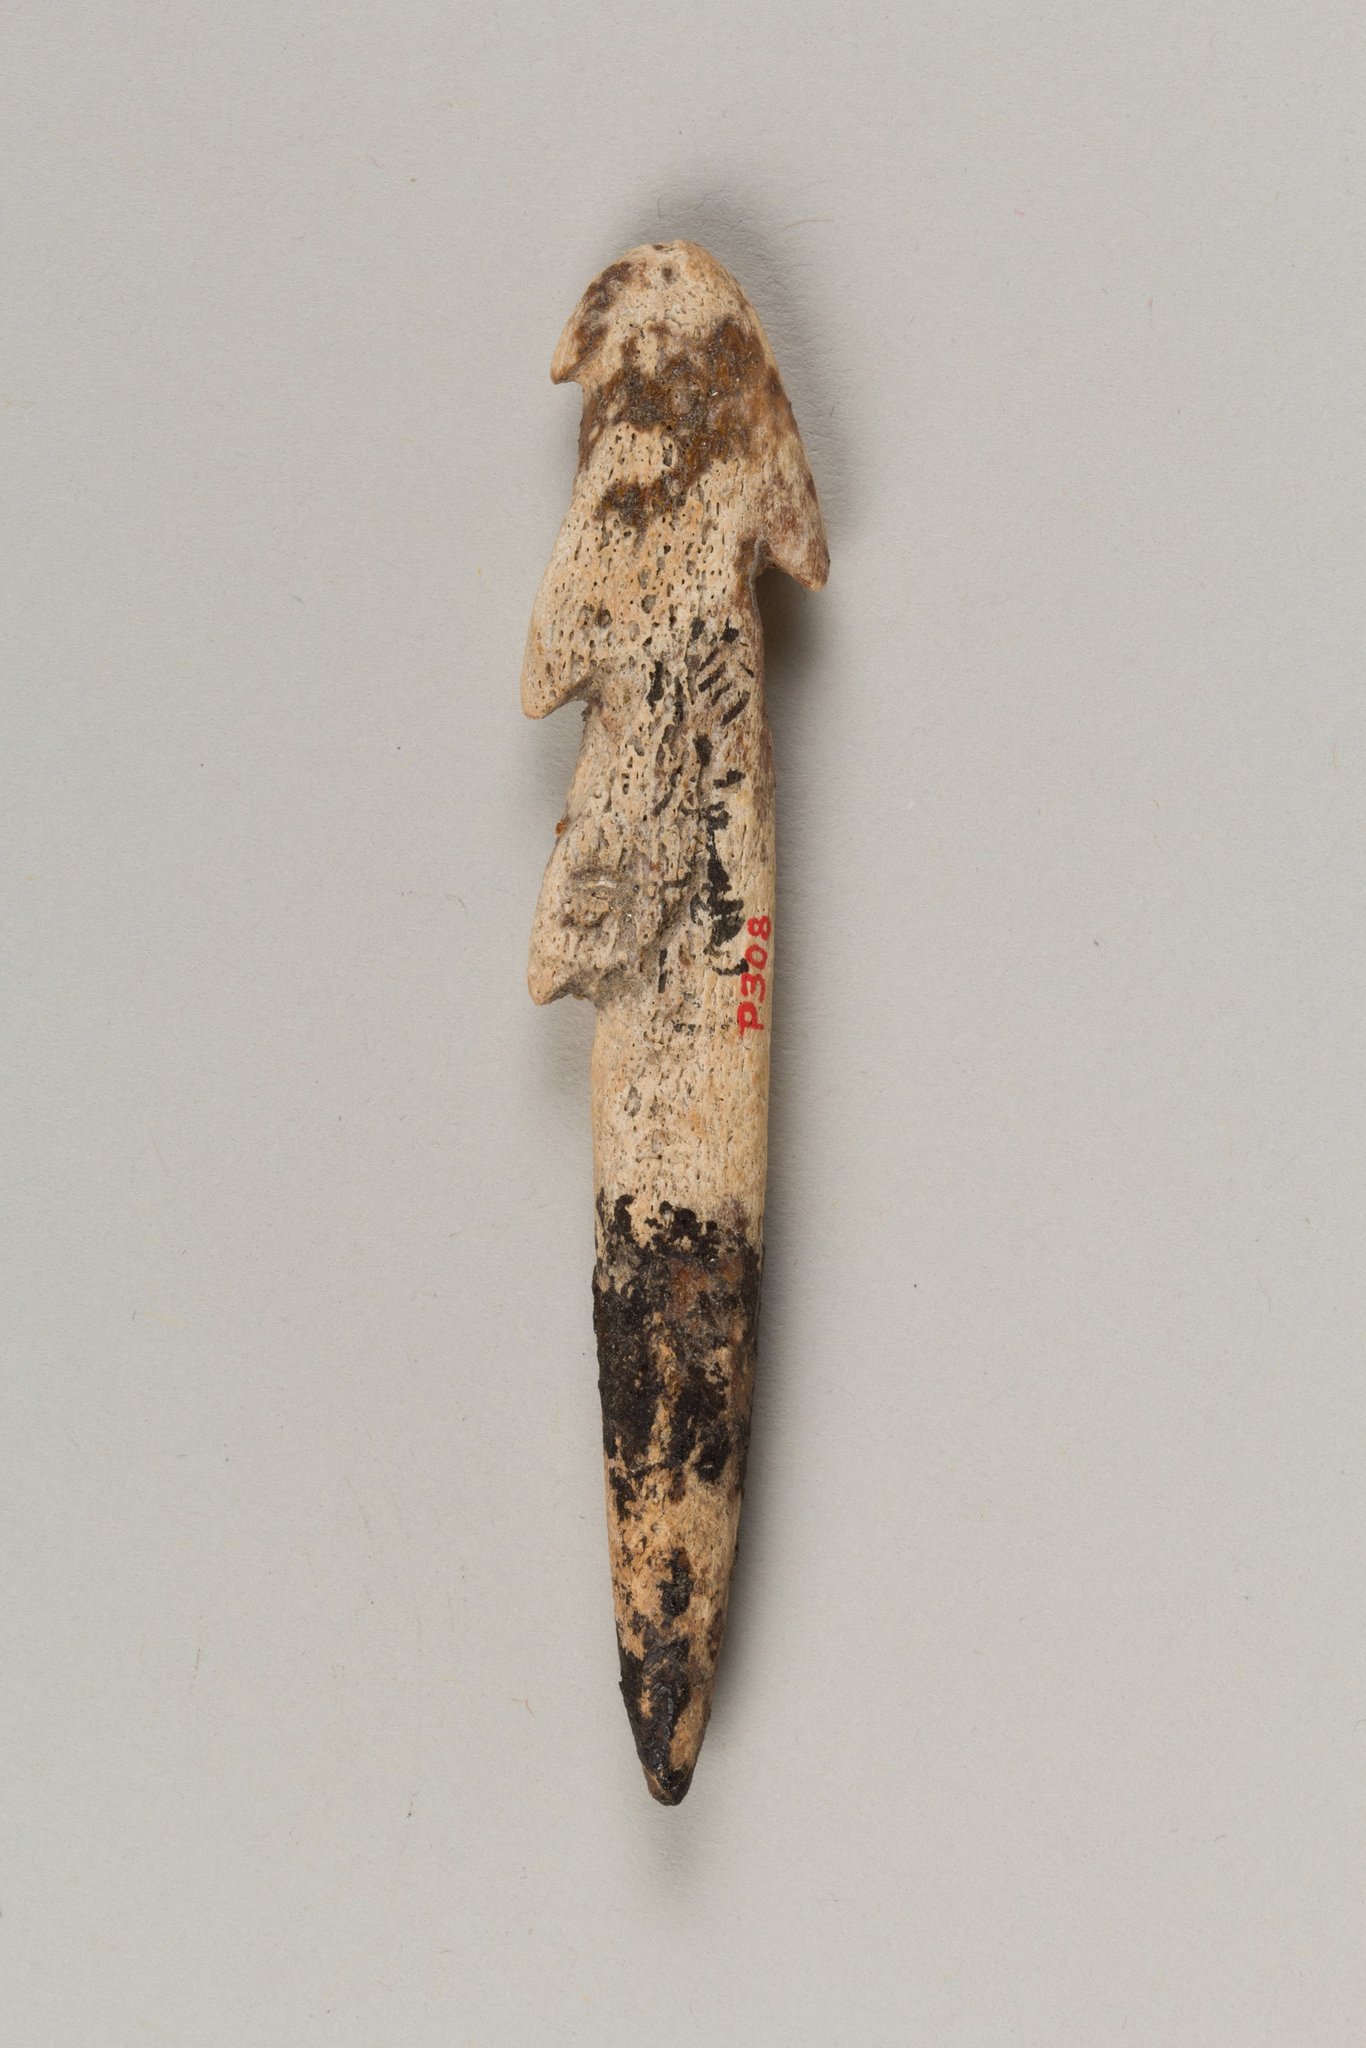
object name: harpoon head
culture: japanese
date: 1000-300 BCE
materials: bone